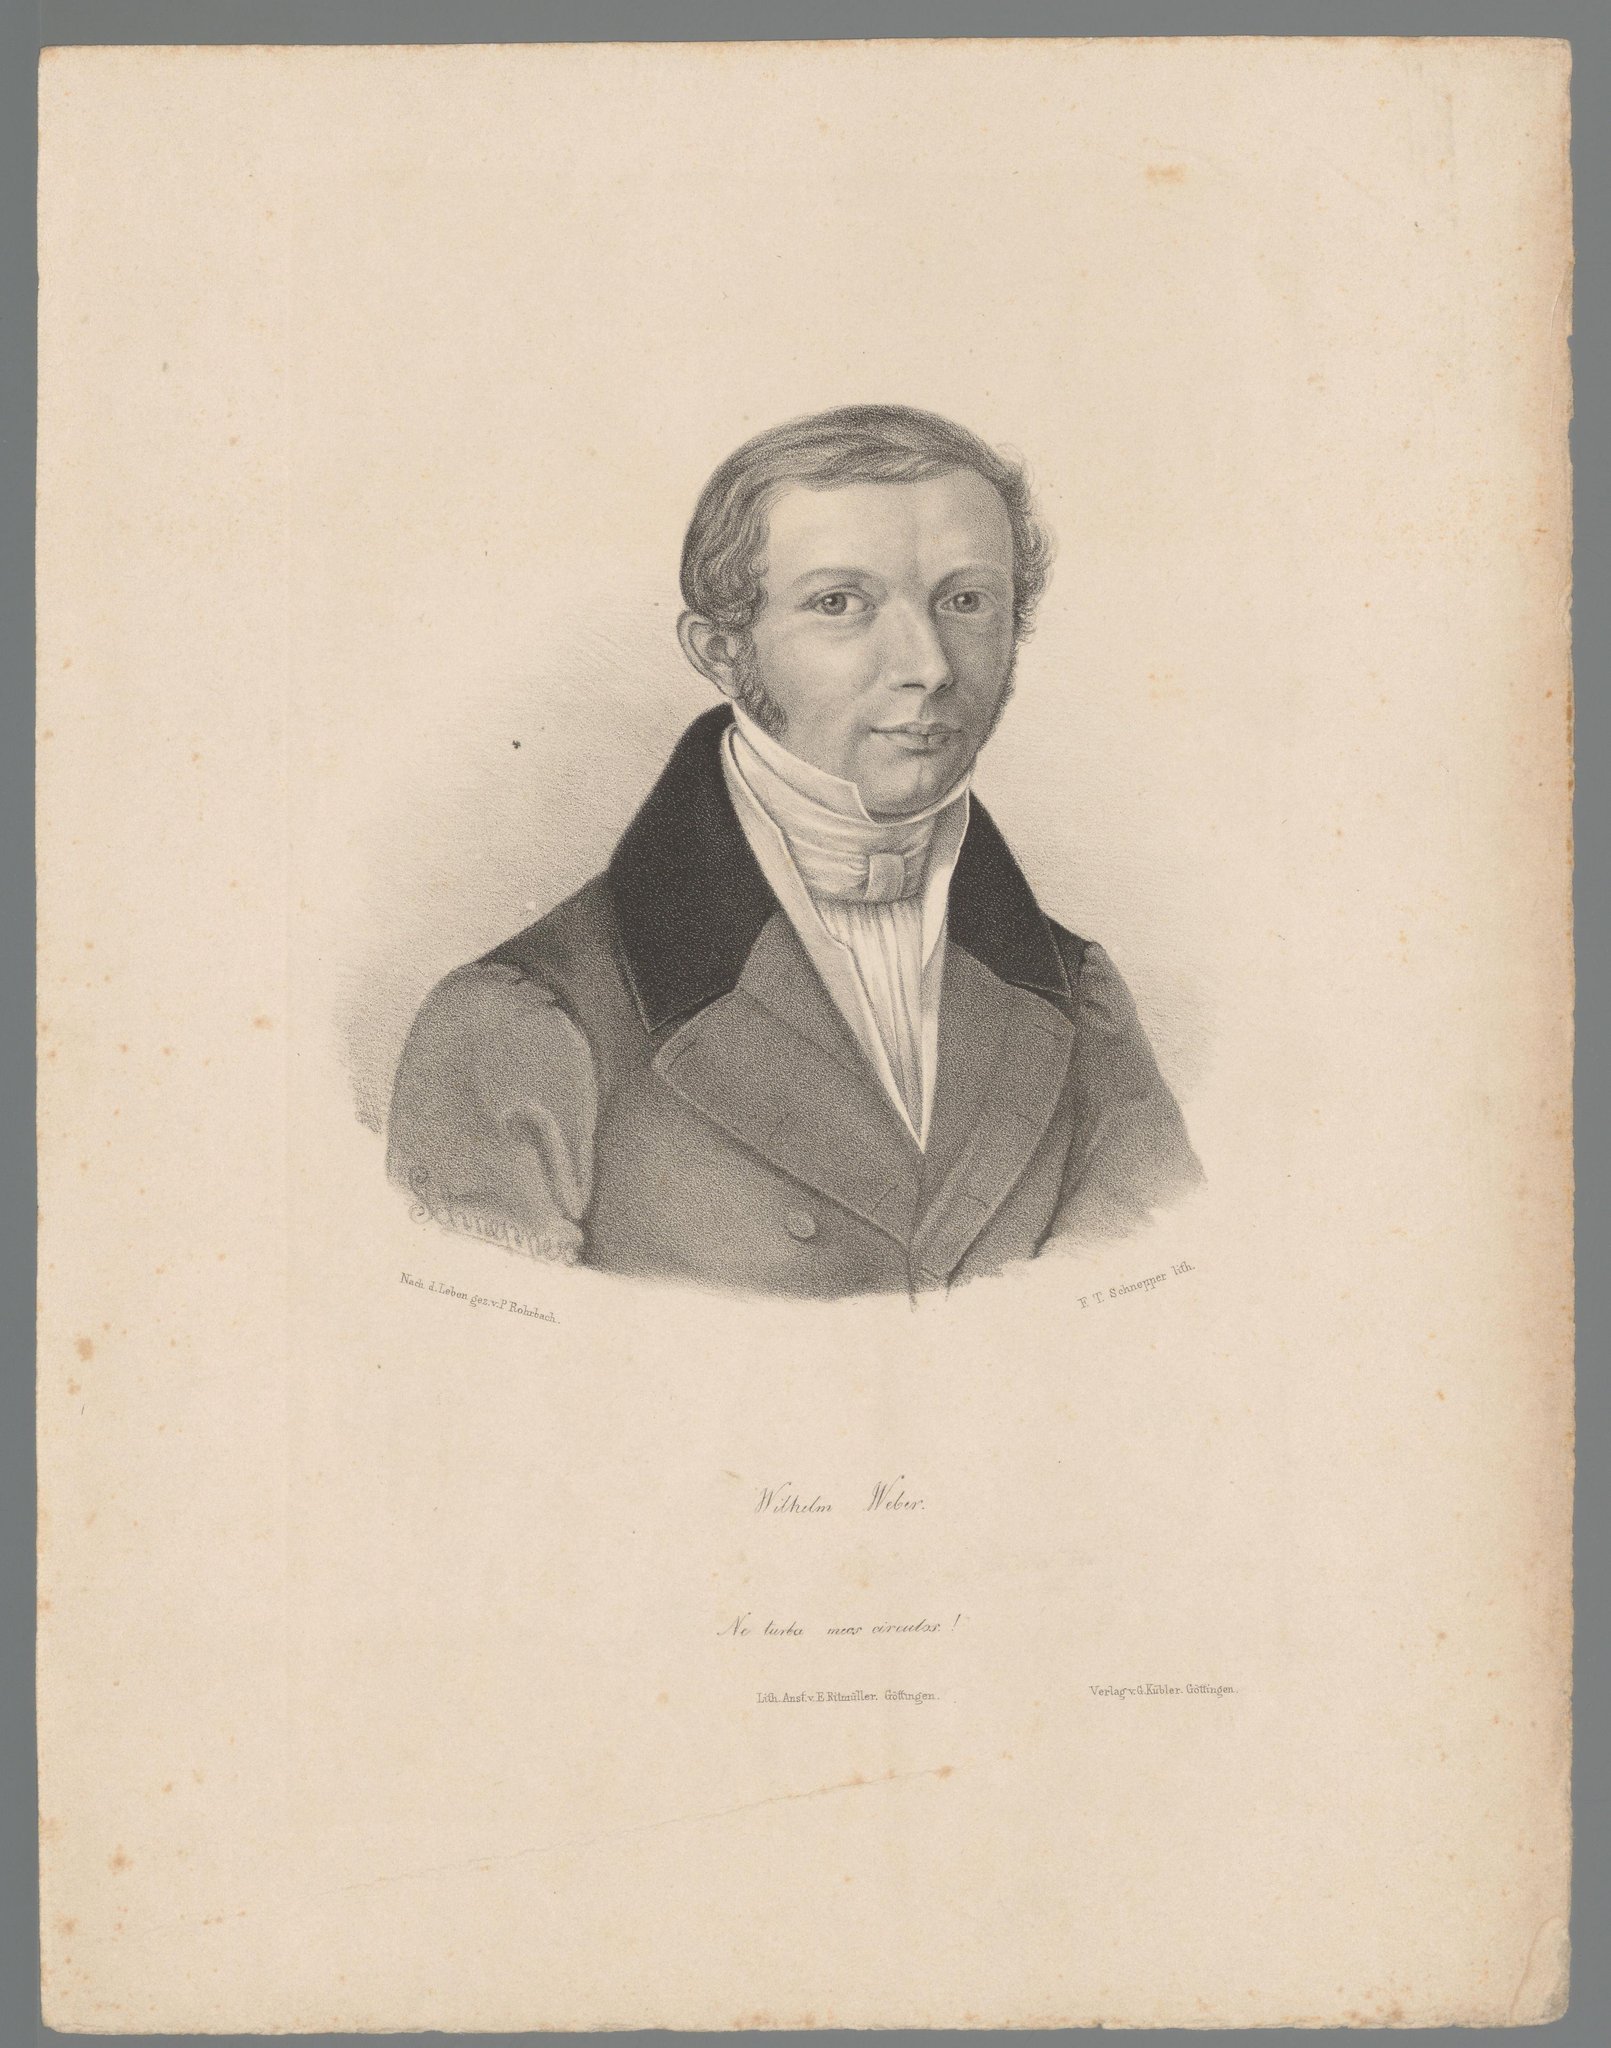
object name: print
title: Portret van Wilhelm Eduard Weber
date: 1827-1862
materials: paper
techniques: lithograph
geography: gottingen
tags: physicist, historical persons, professor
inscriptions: collector's mark: Lugt 2228